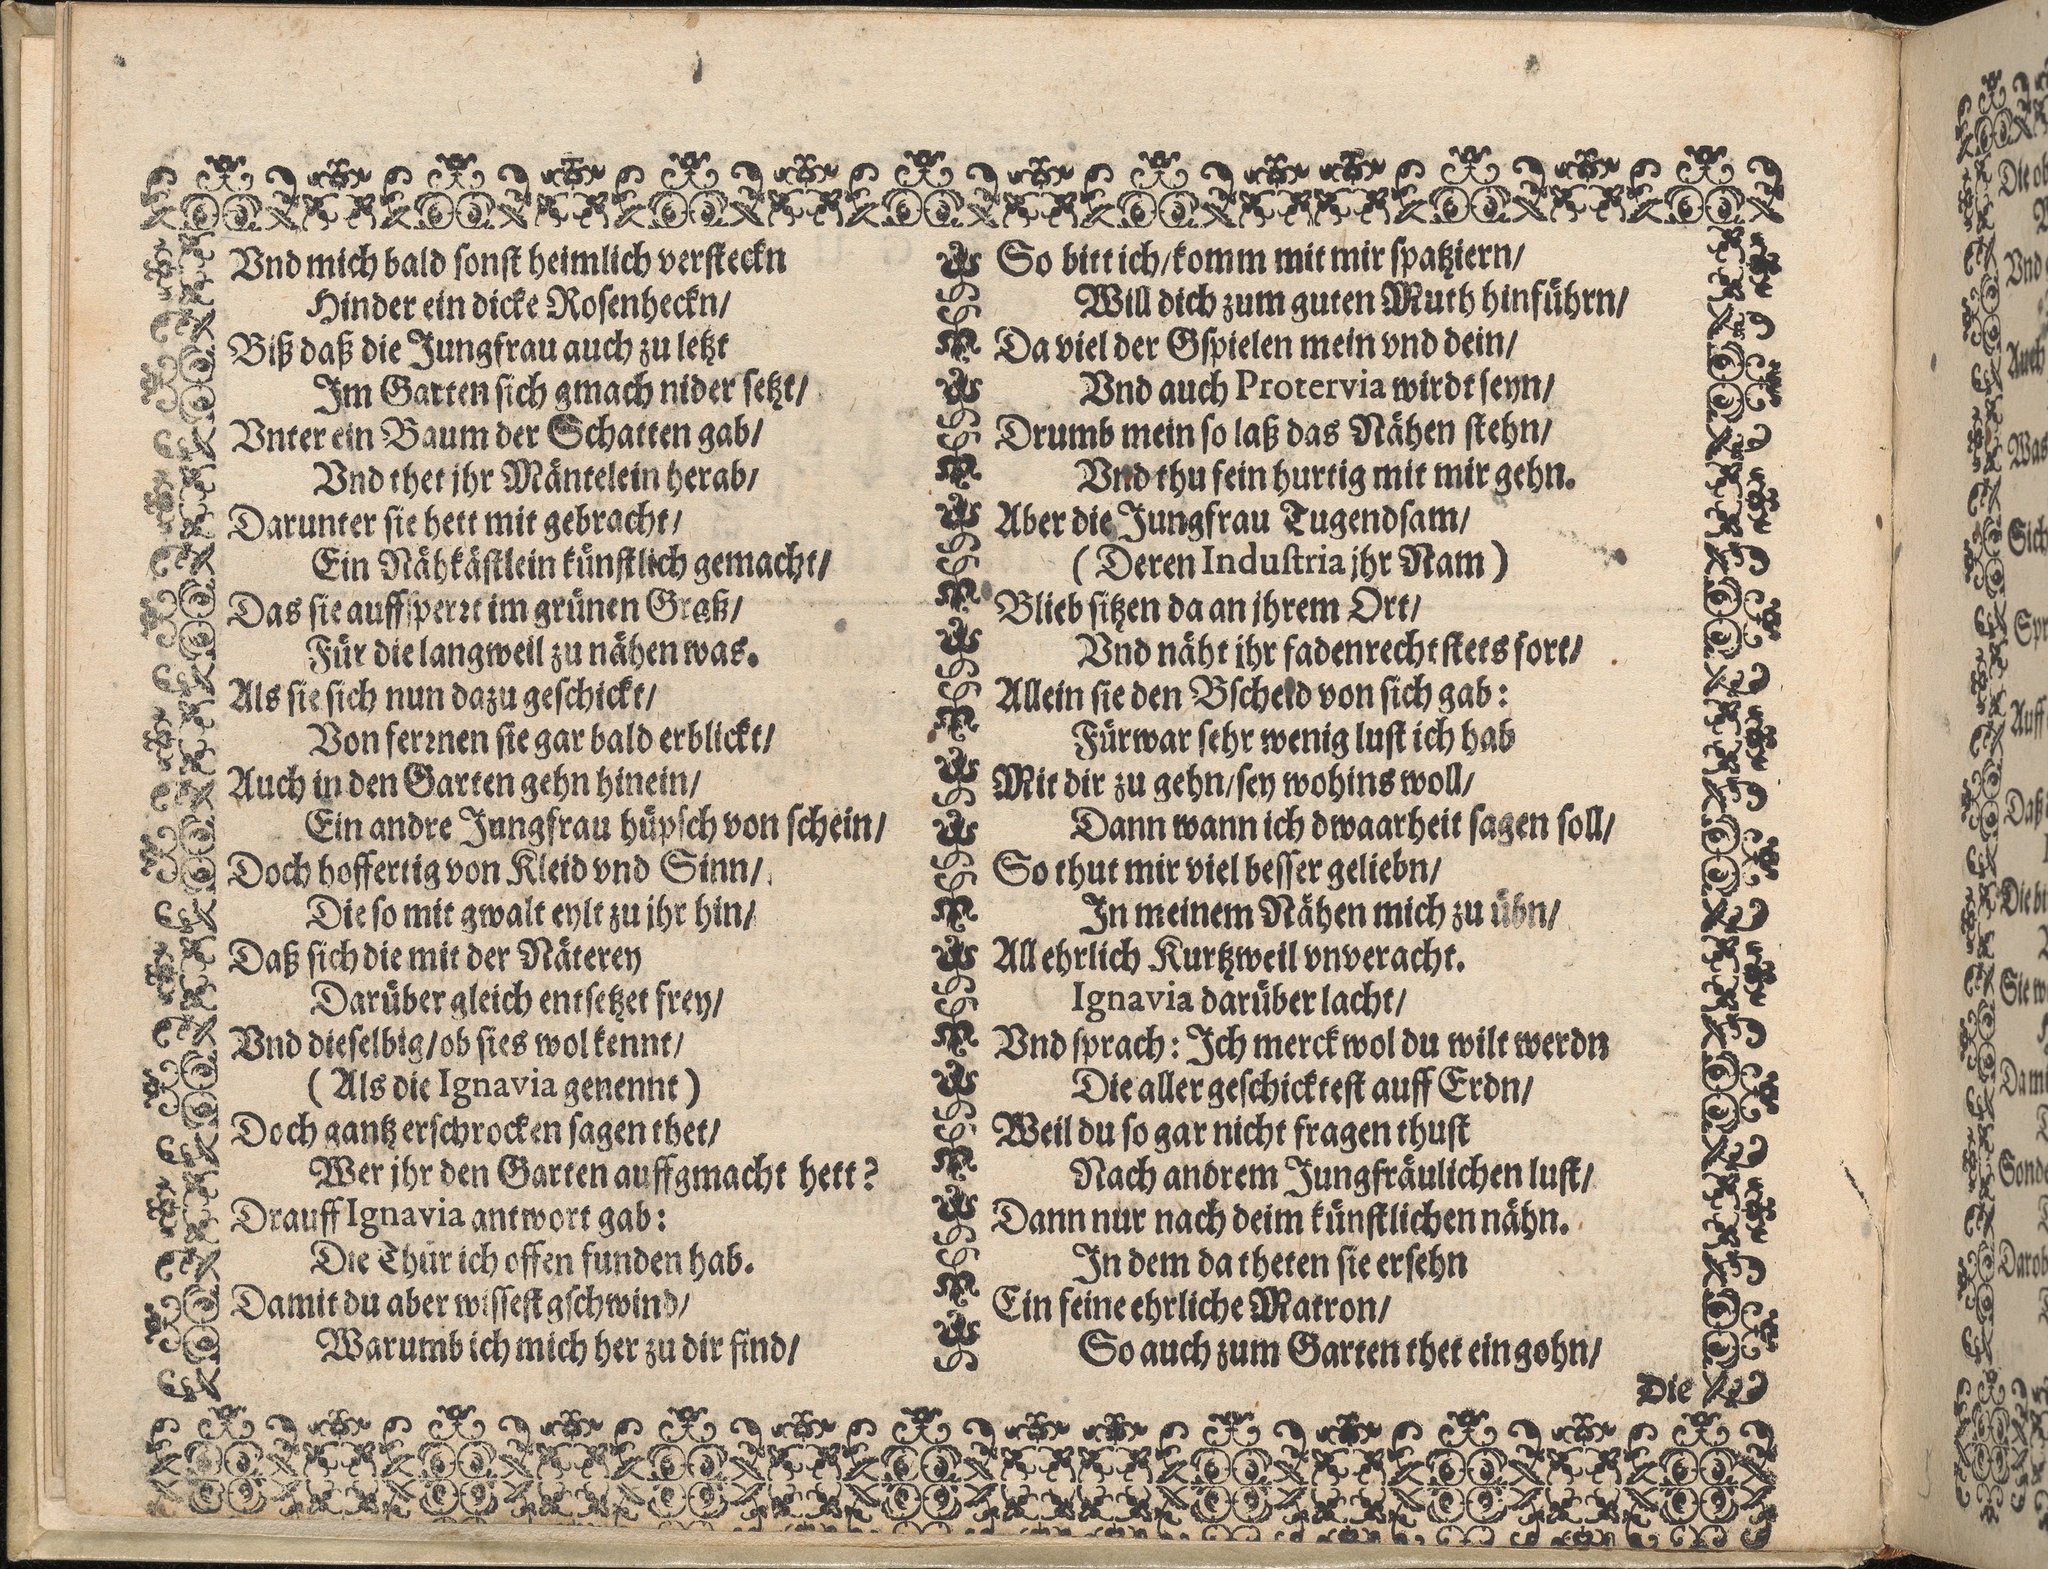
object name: book print ornament architecture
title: Newes Modelbuch in Kupffer (Page 4r)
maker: johann sibmacher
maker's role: artist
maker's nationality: german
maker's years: 1590-1611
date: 1604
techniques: woodcut